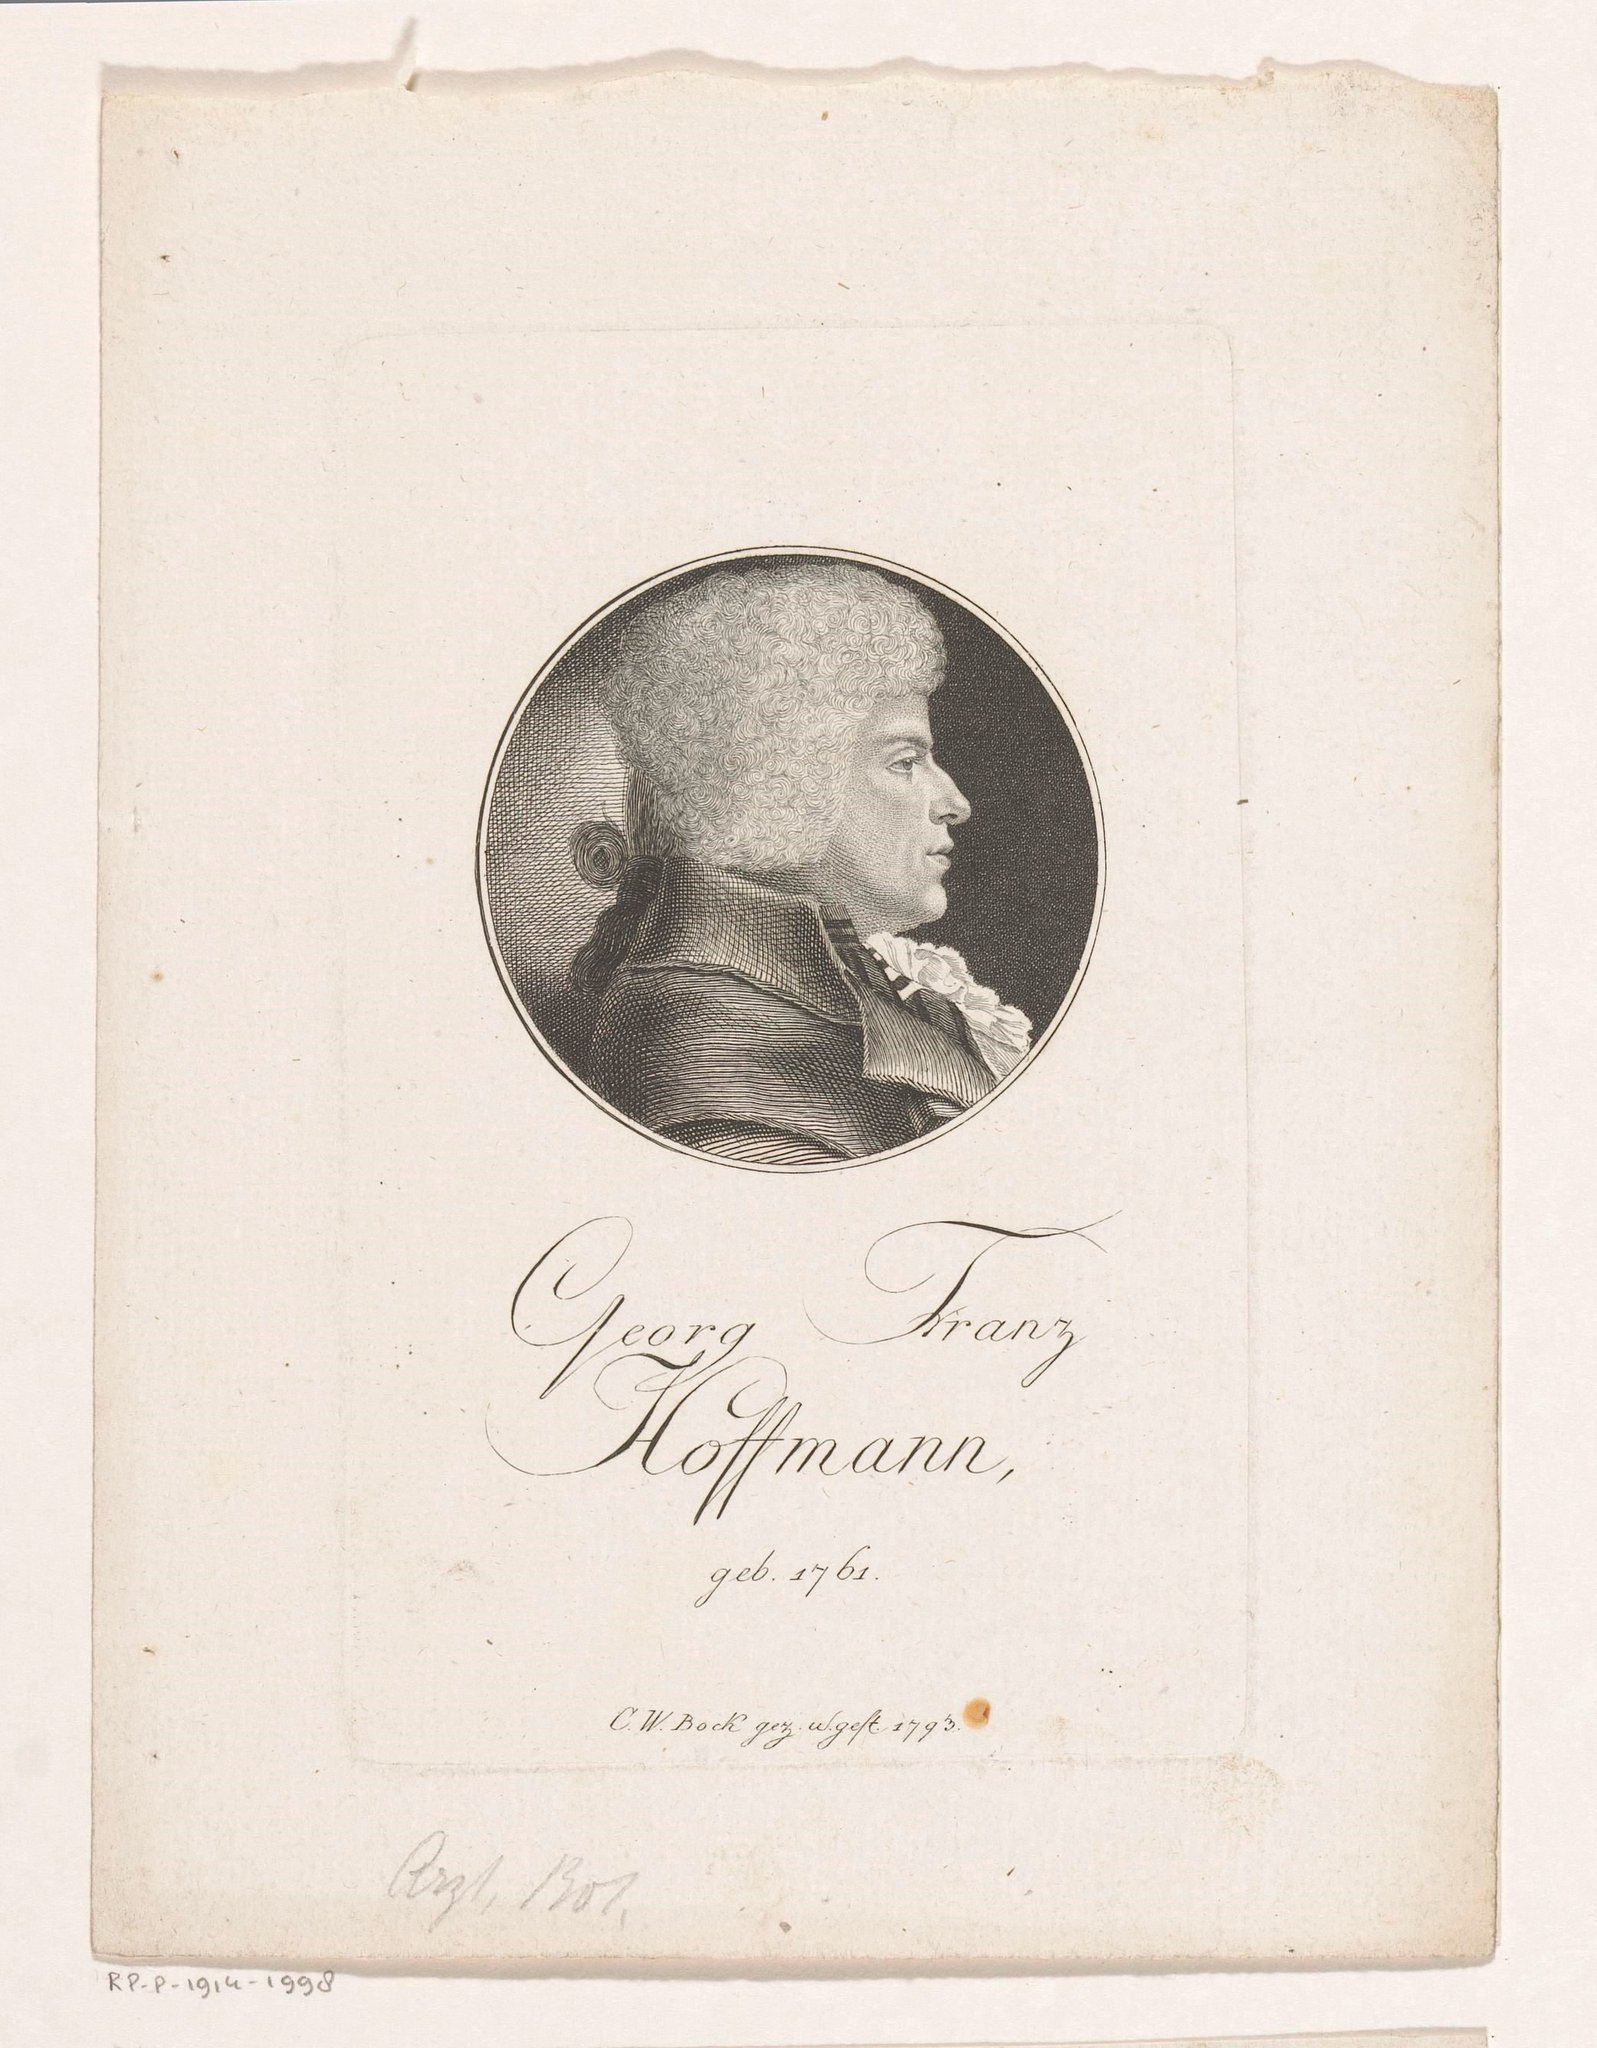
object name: print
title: Portret van Georg Franz Hoffmann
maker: christoph wilhelm bock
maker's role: print maker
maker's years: 1755-1836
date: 1793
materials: paper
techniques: engraving, etching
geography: nuremberg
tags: historical persons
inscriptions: collector's mark: Lugt 2228